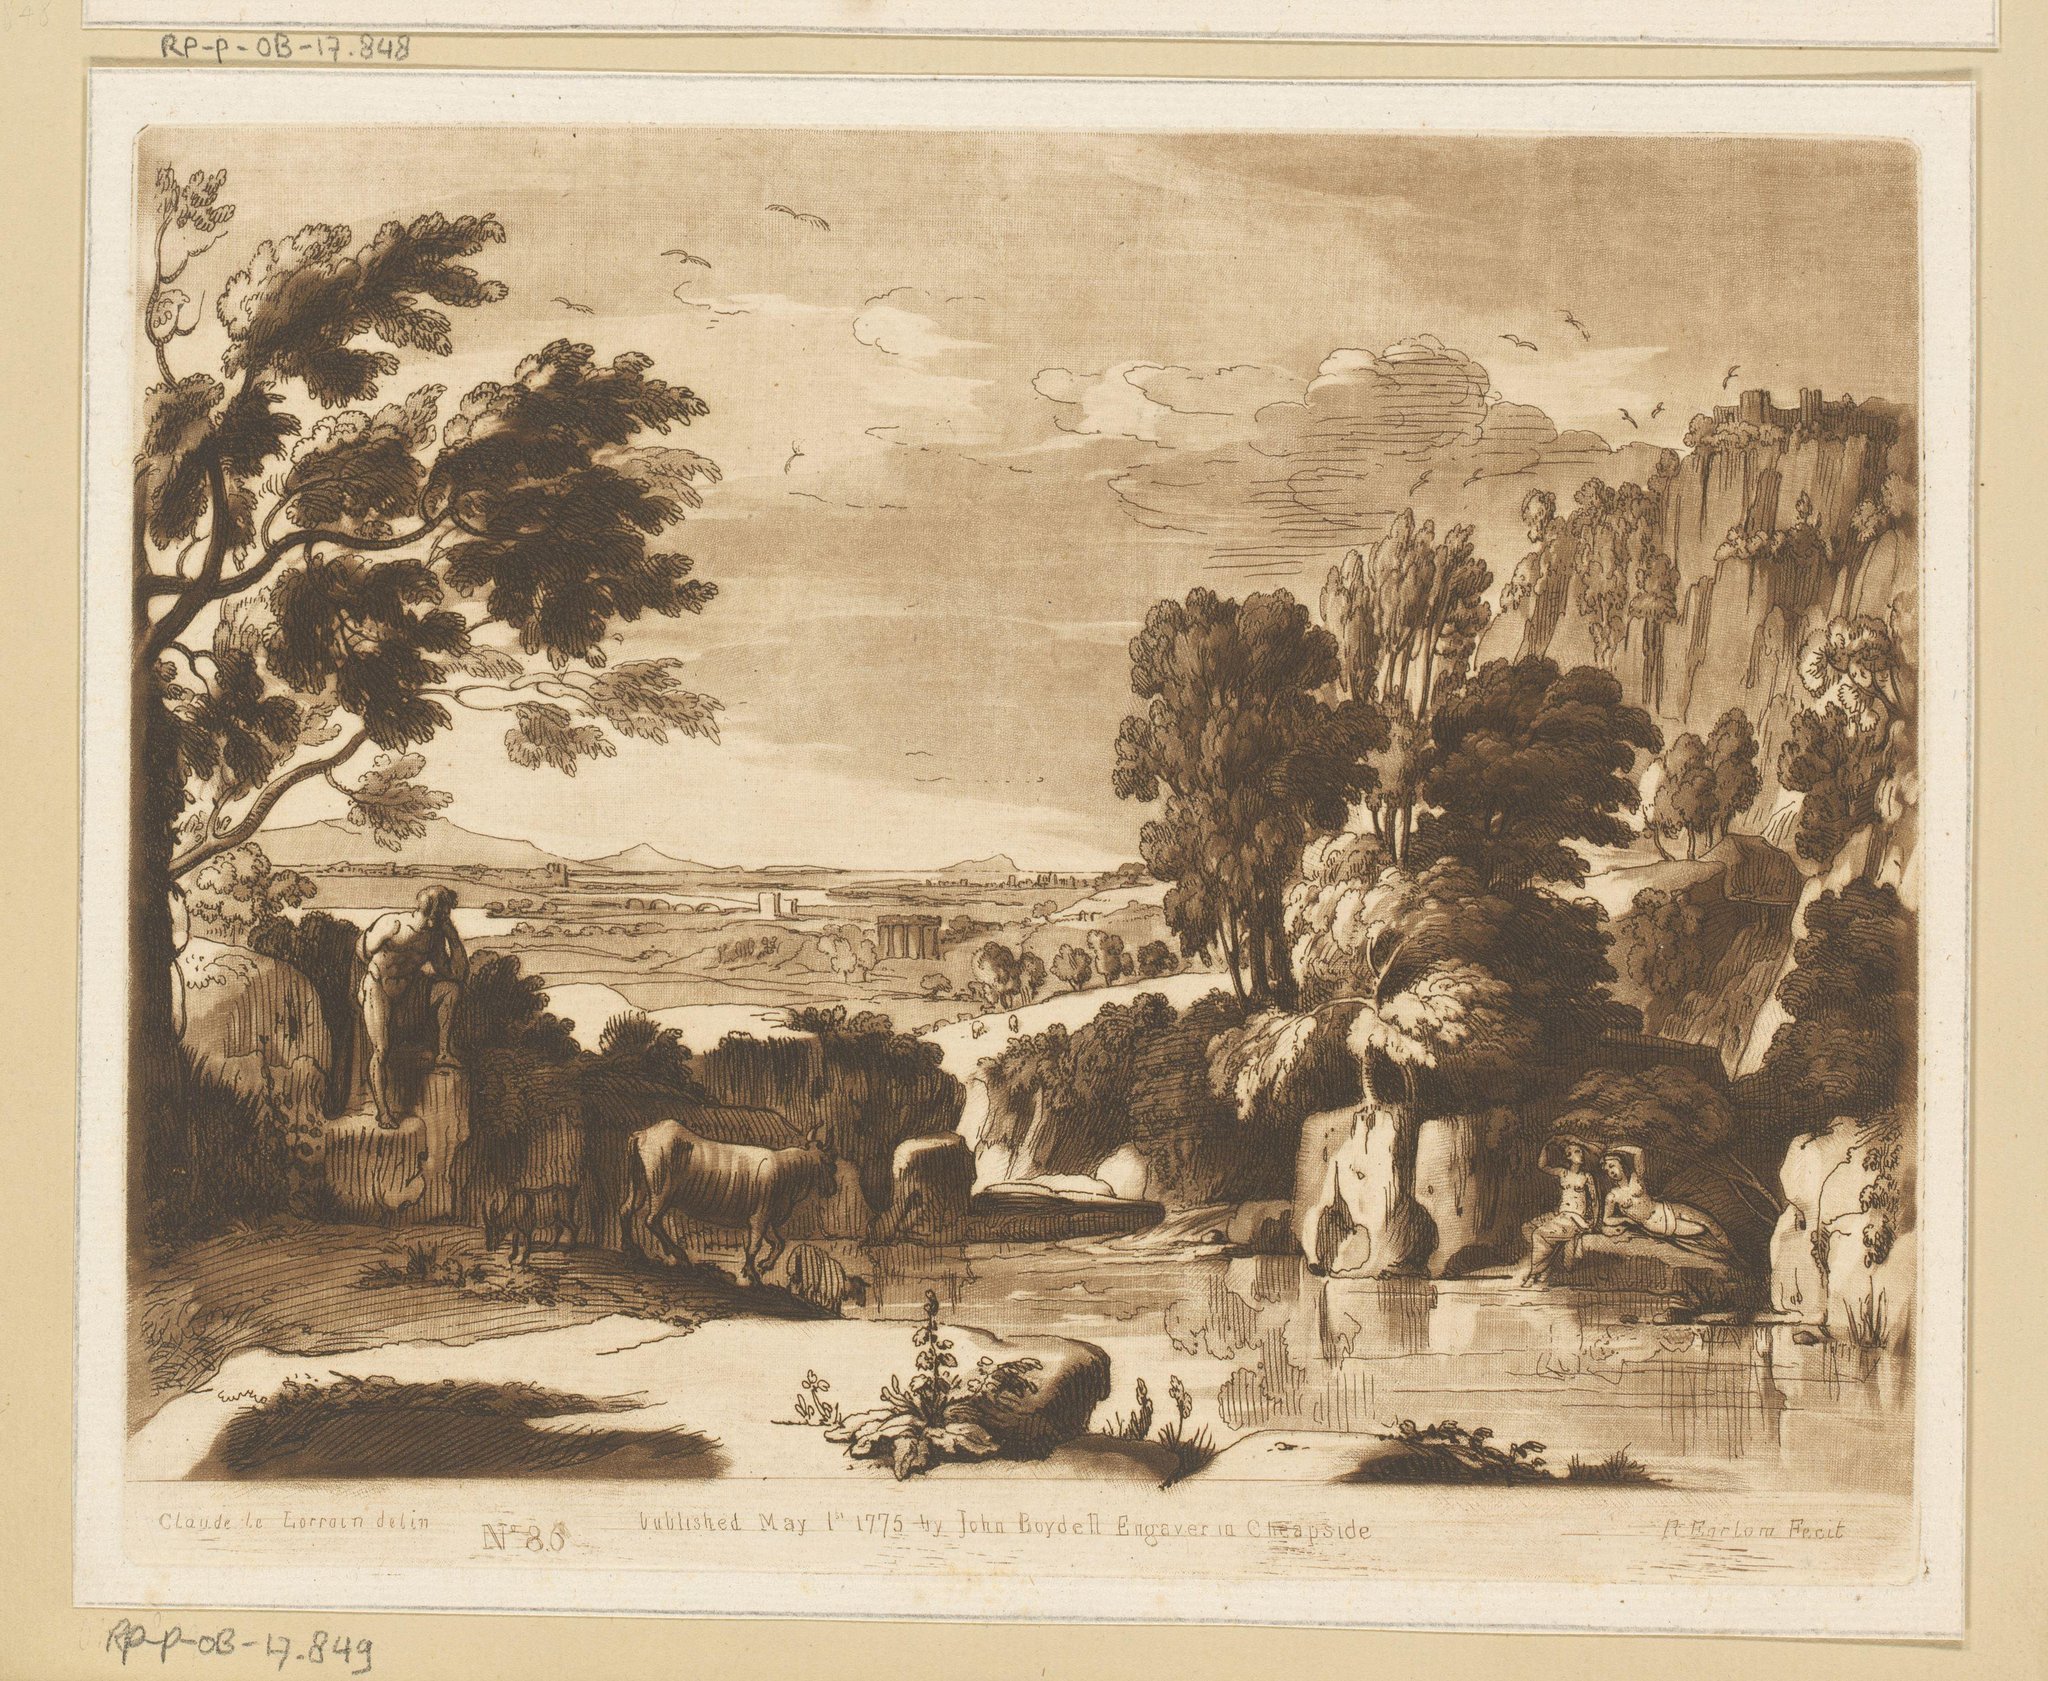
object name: print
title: Landschap met badende figuren en kasteel op hoge klif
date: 1775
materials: paper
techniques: etching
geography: london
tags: inland cliff face, landscape with ruins - ii - ideal landscapes, lake (+ landscape with figures, staffage)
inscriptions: date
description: Vanaf 1774 publiceerde John Boydell tweehonderd prenten naar het tekeningenboek Liber Veritatis van Claude Lorrain, in het bezit van de hertogen van Cavendish. Deze prenten werden vanaf 1777 in twee volumes gebundeld uitgegeven.